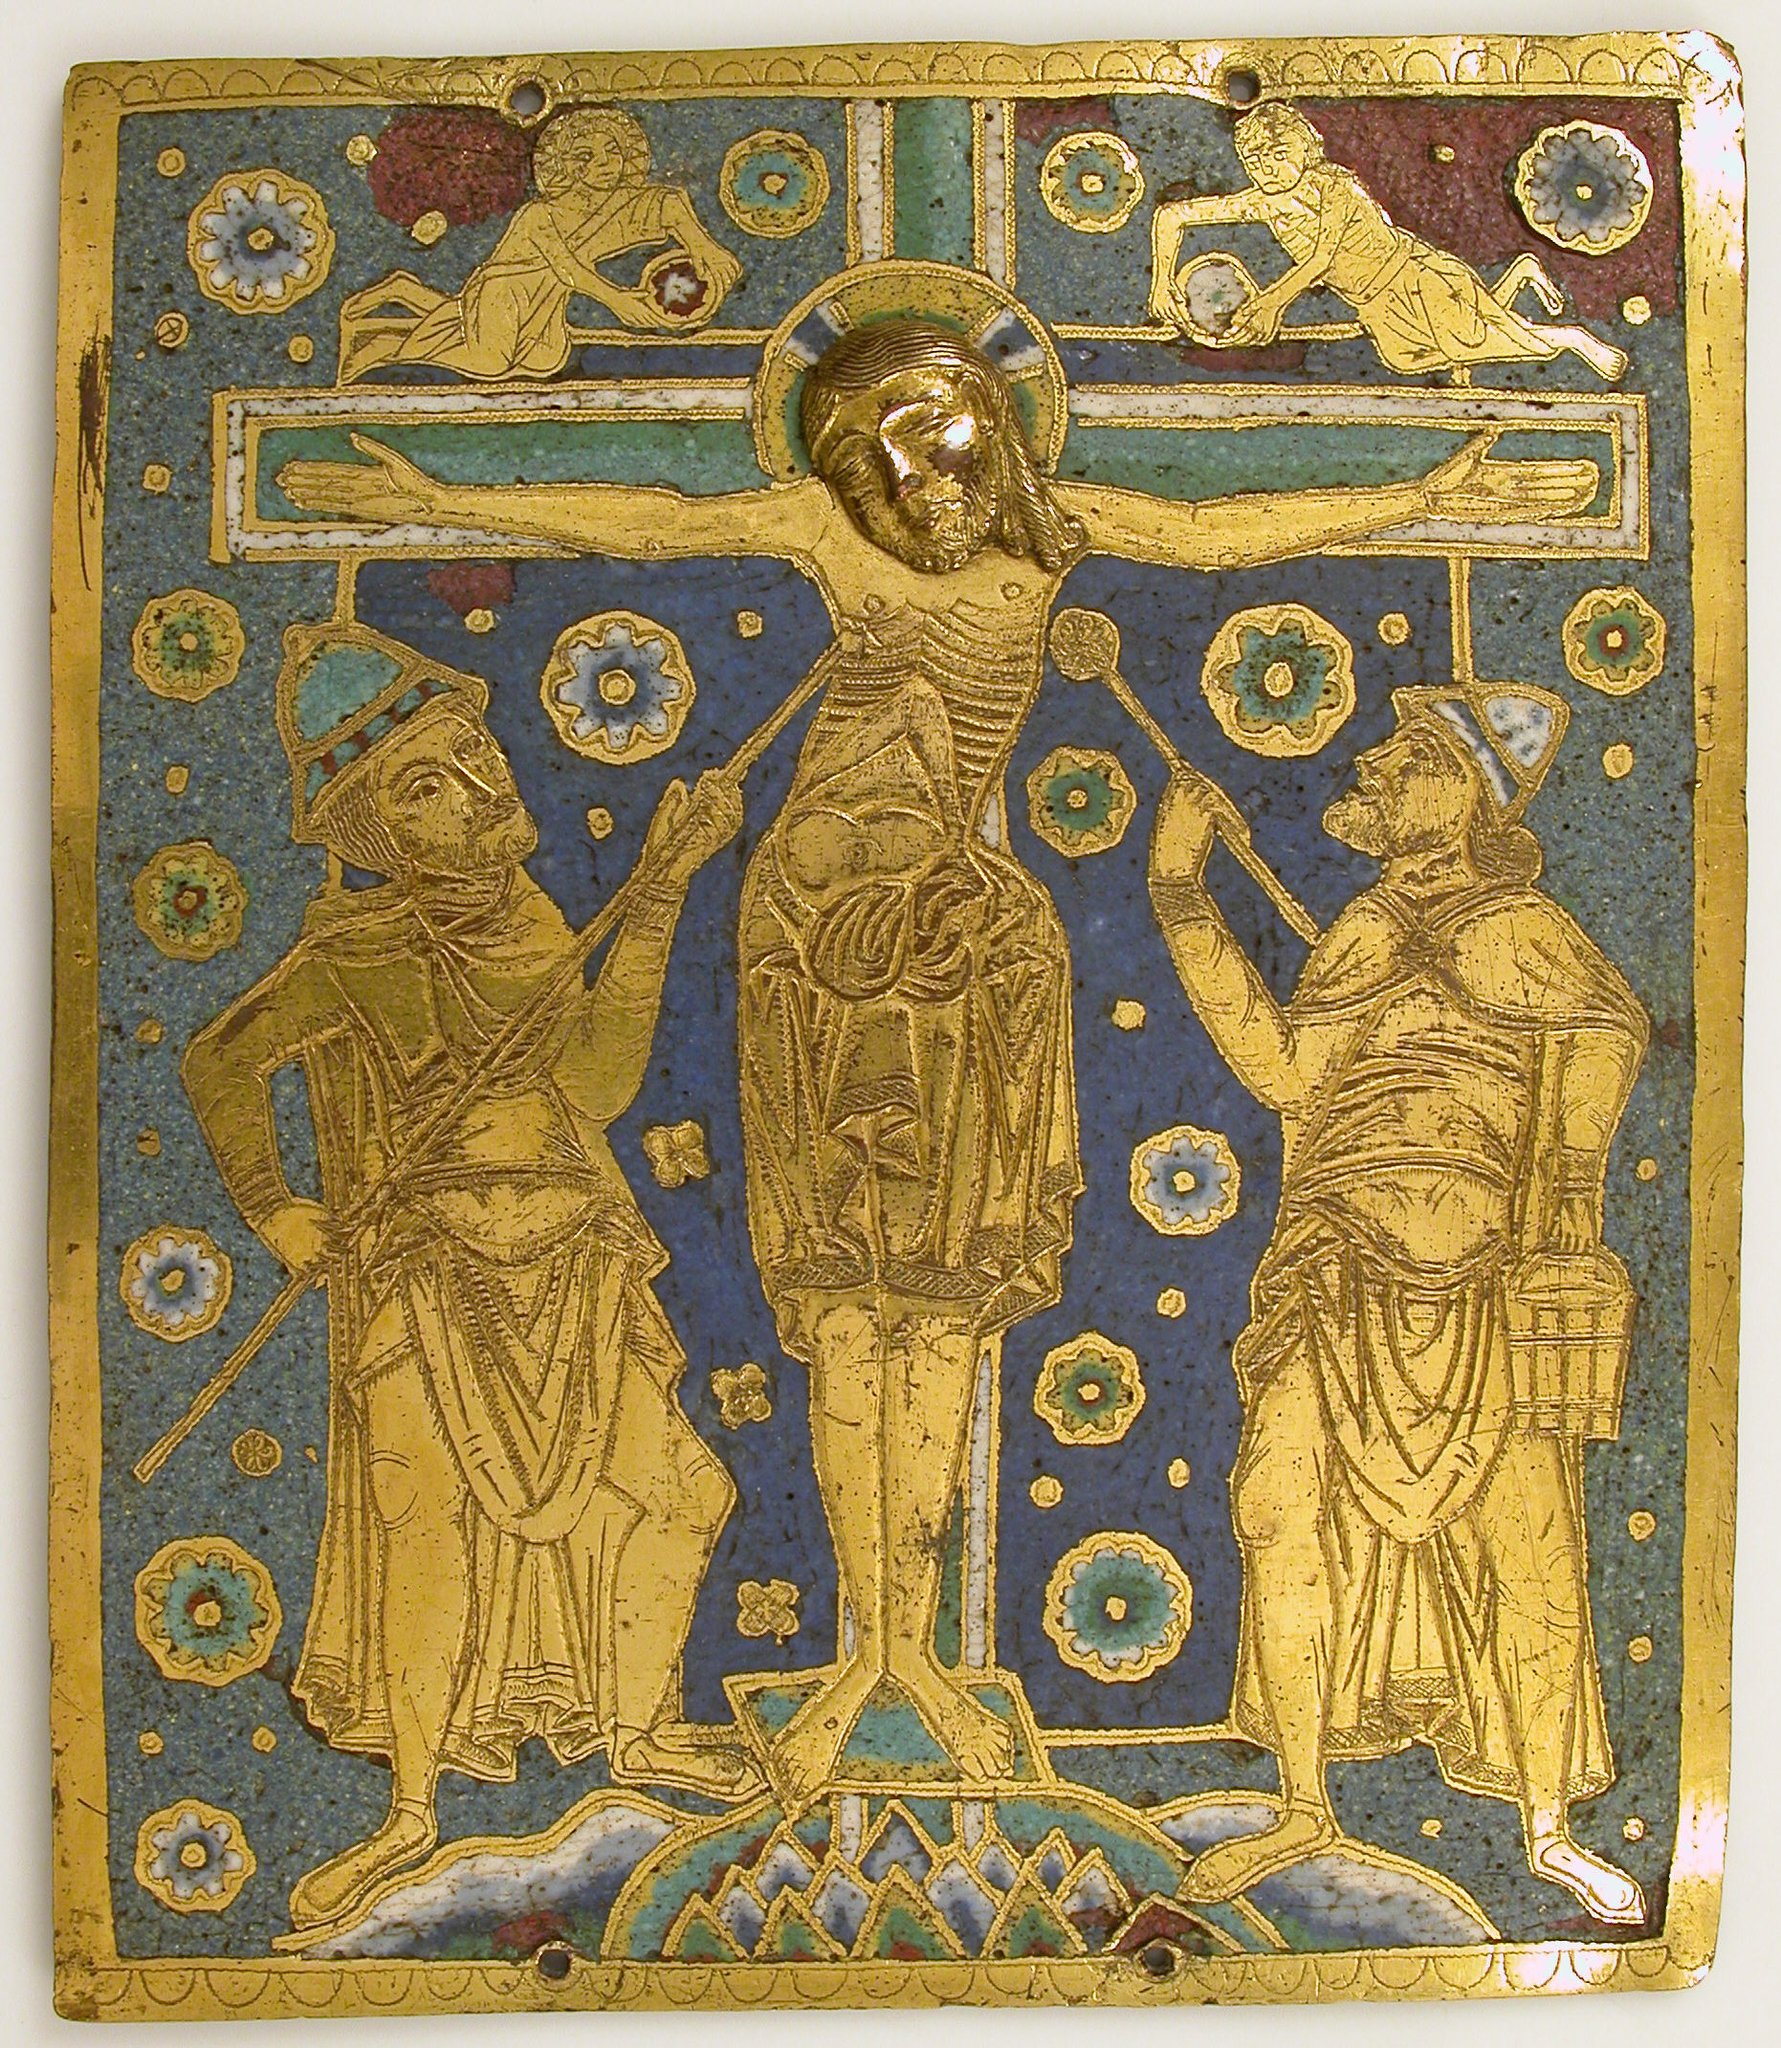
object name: plaque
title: Plaque with the Crucifixion between Longinus and Stephaton and Personifications of the Sun and Moon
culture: german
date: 1200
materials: copper, enamel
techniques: enamel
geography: germany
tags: soldiers,christ,crucifixion